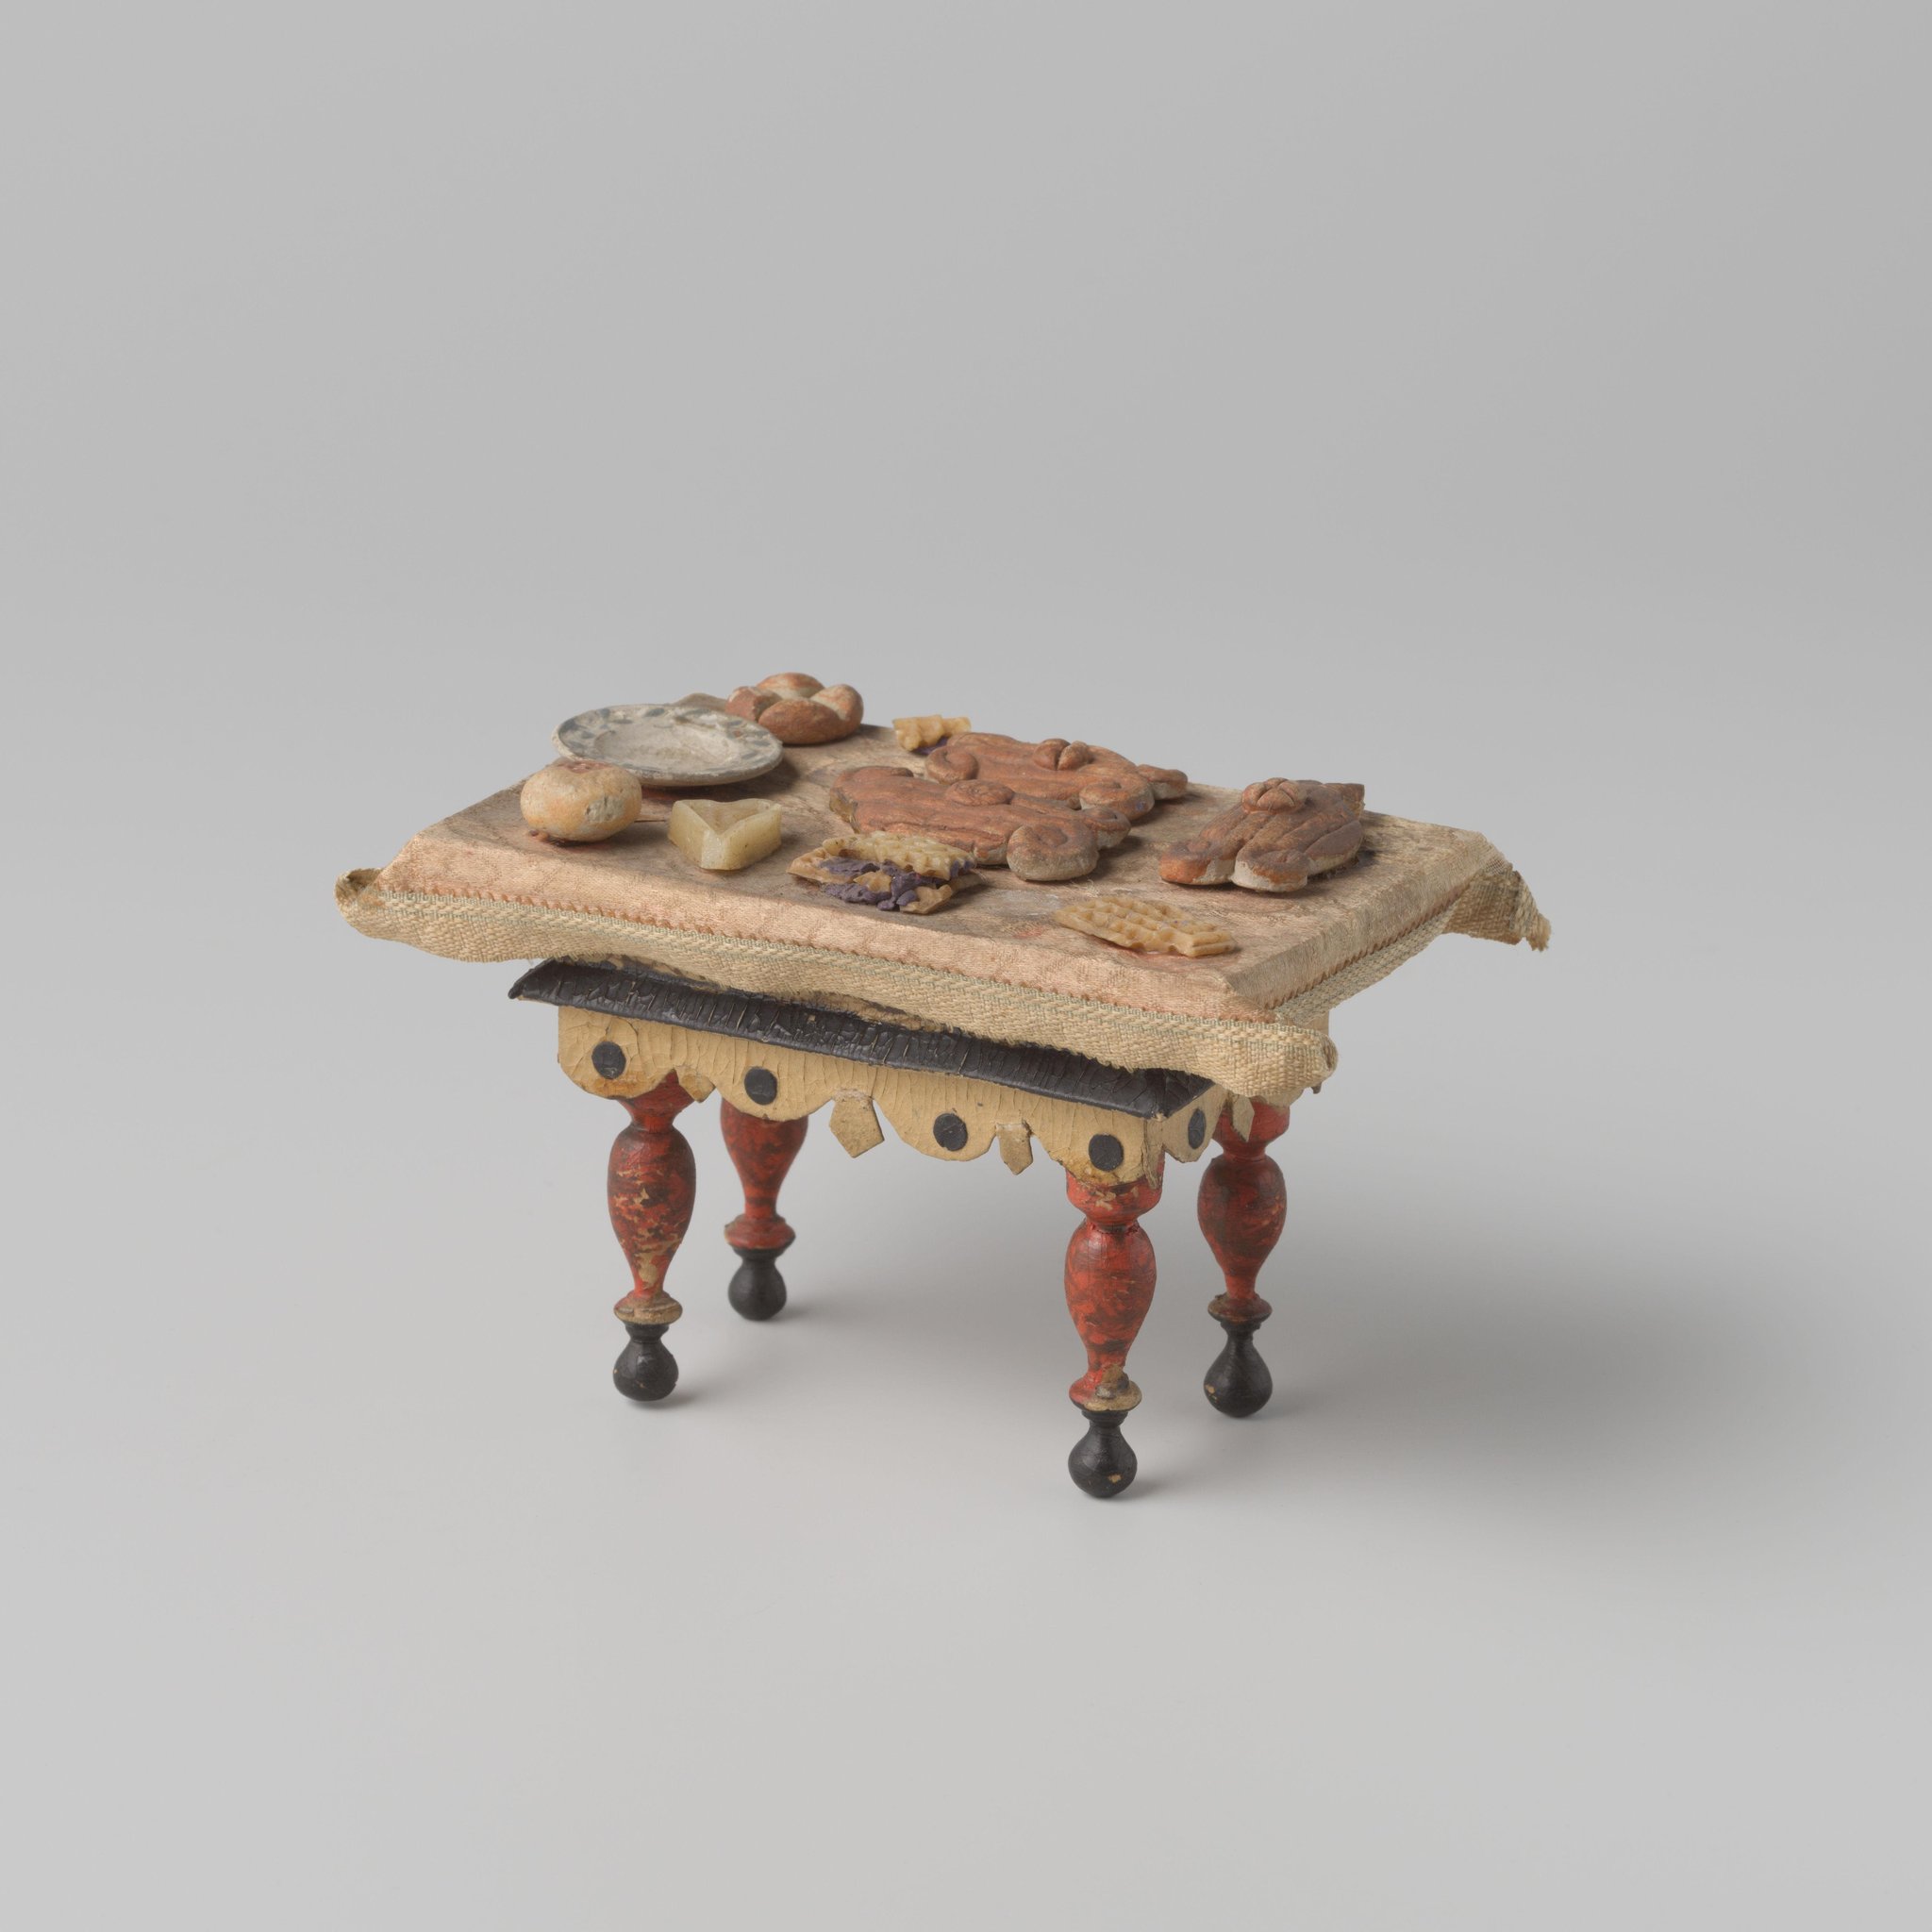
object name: table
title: Tafel met etenswaren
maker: Anonymous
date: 1676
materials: board, silk, wood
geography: amsterdam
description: Tafel, rechthoekig, vervaardigd van hout en bordpapier bedekt met een tafelkleed waarop etenswaren. De tafel bestaat uit een massief houten blok met zwarte uitstekende rand en puntige of gebogen versieringen van bordpapier, lichtgeel geverfd met zwarte stippen. Het blok rust op vier balustervormige poten, gemarmerd rood gelakt met zwarte bolpoten. Op het blok ligt een tafelblad, beplakt met pepier en een tafelkleed van roze zijde met ingeweven geometrisch patroon, afgezet met beigekleurig zijdeband met lichtblauwe draad. Op het kleed zijn etenswaren en een geschilderd bord geplakt: drie 'duivenkaters' en een rond brood, vier wafels, een kaas en voedsel in de vorm van een hart.